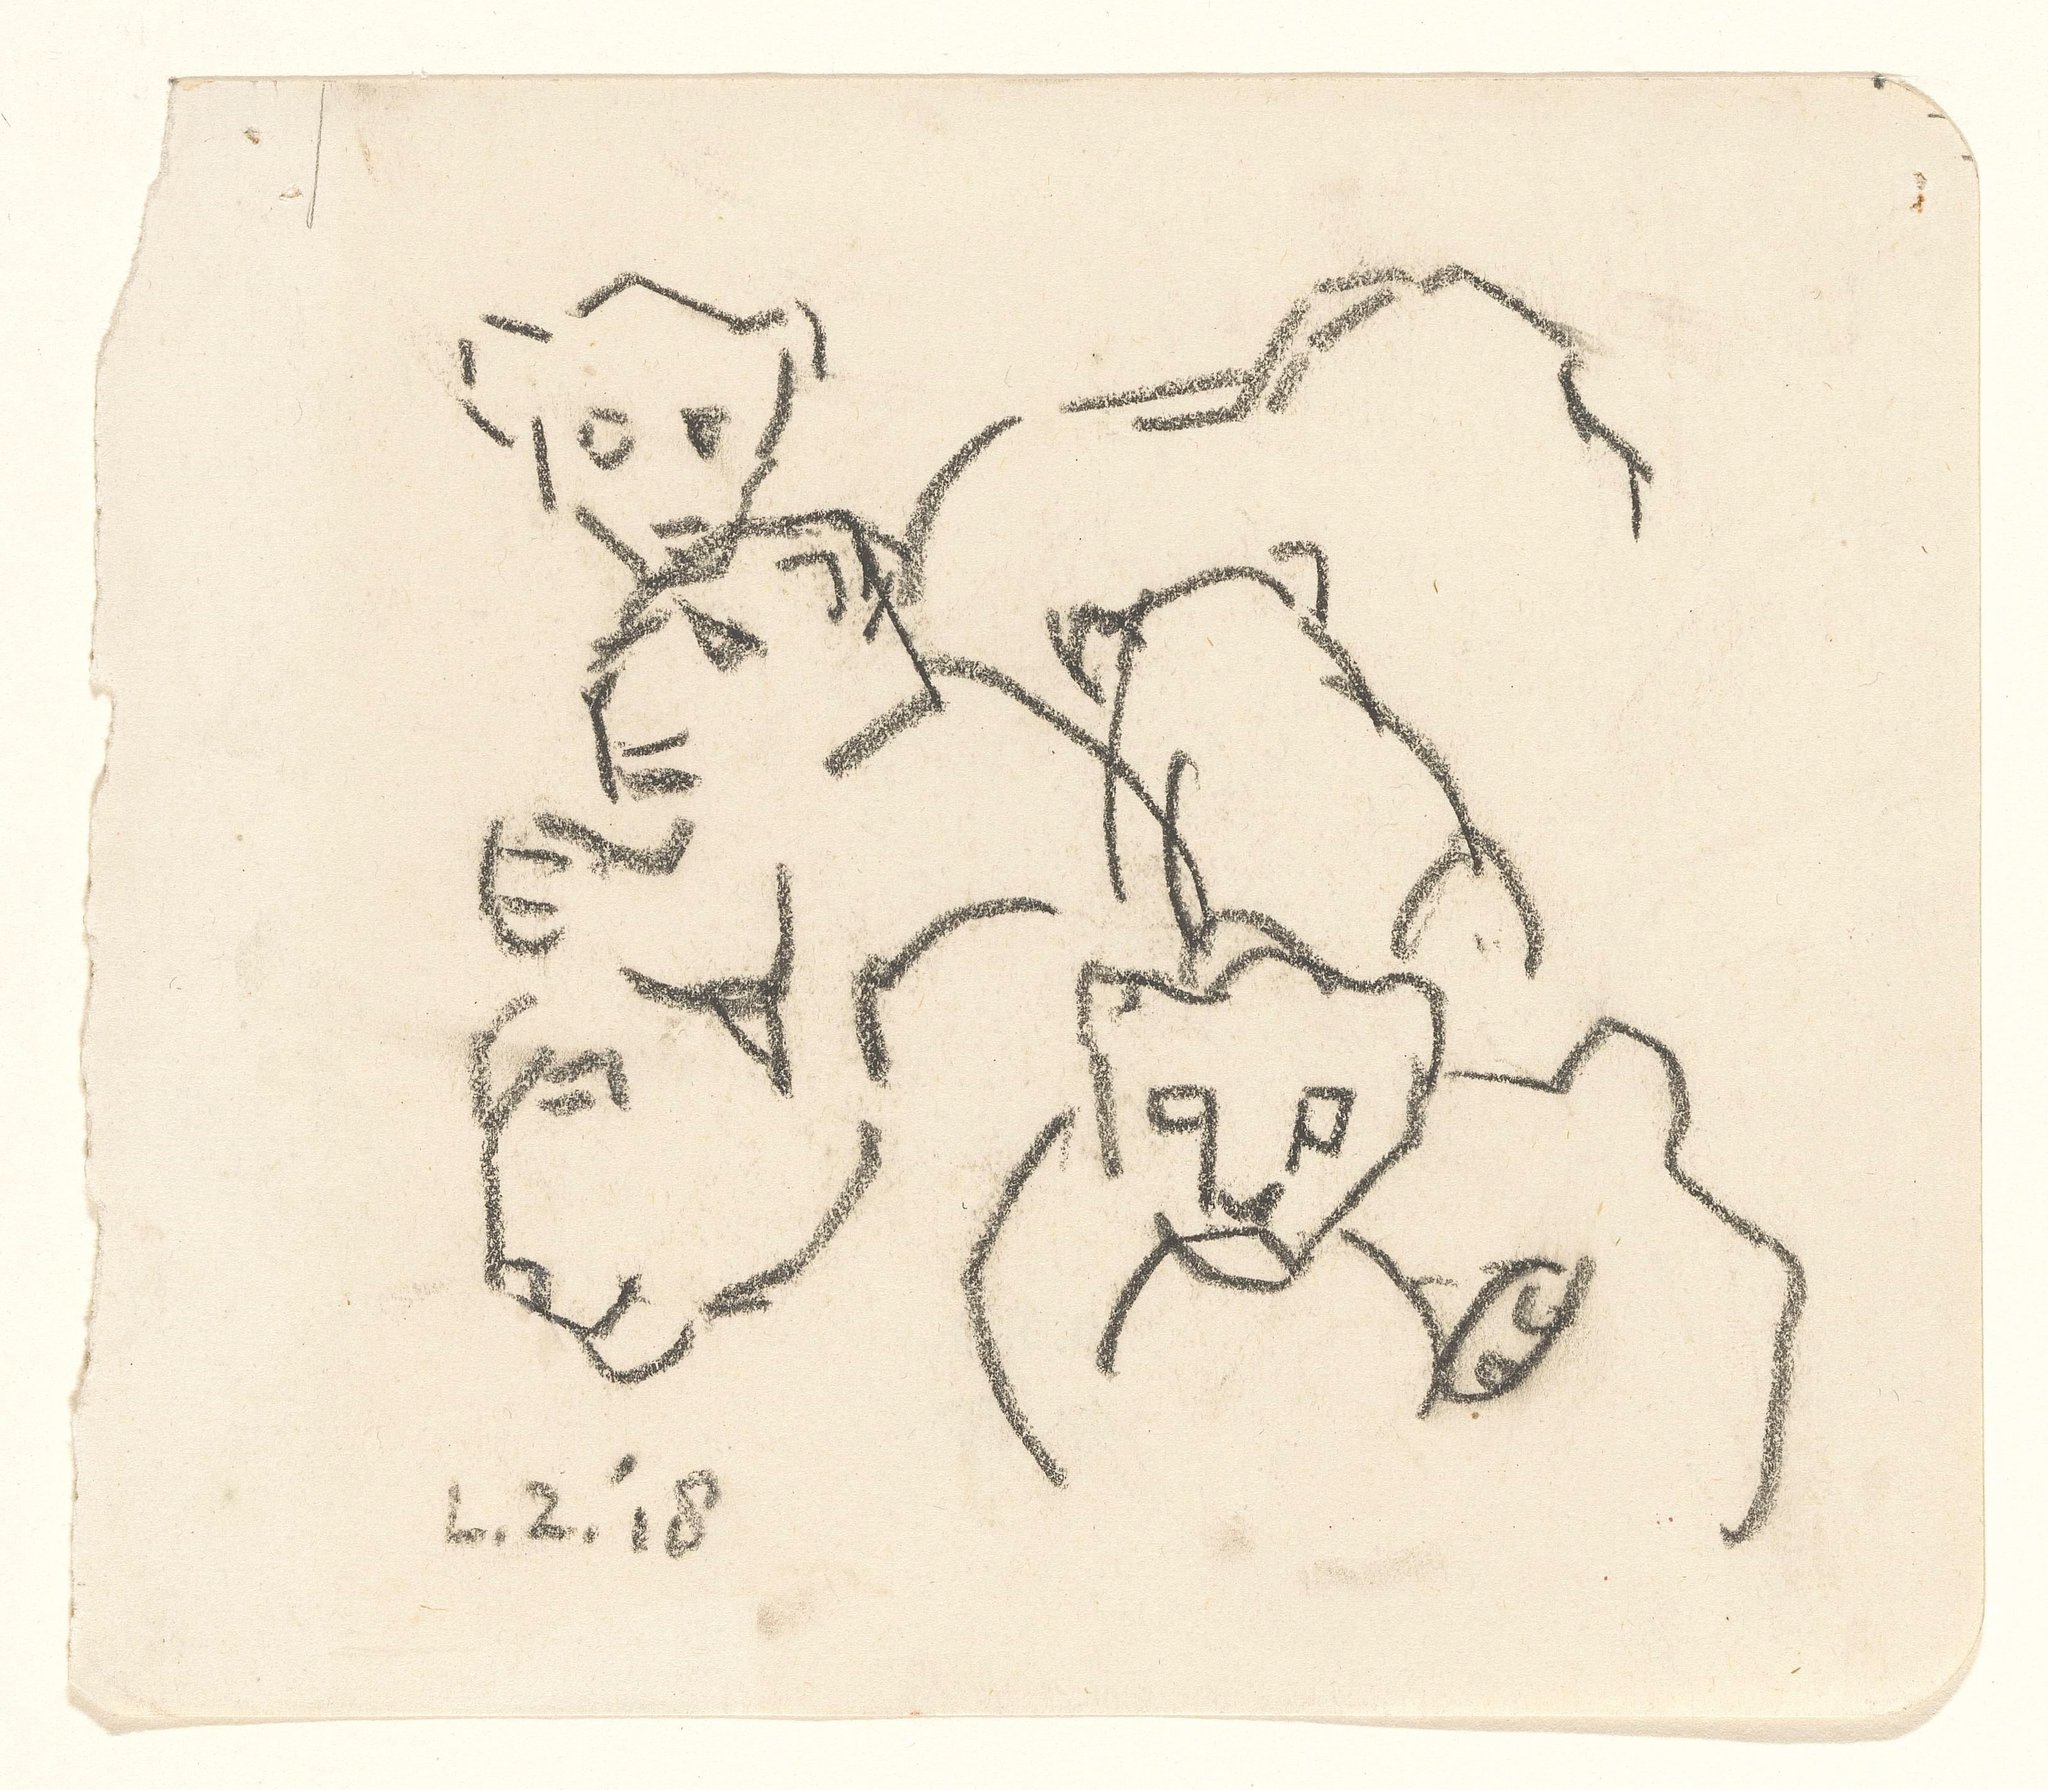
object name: drawing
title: Schetsen van een leeuwtje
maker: lambertus zijl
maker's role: designer, draughtsman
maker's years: 1866-1947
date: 1918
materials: chalk, paper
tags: beasts of prey, predatory animals: lion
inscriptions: date: ‘'18’